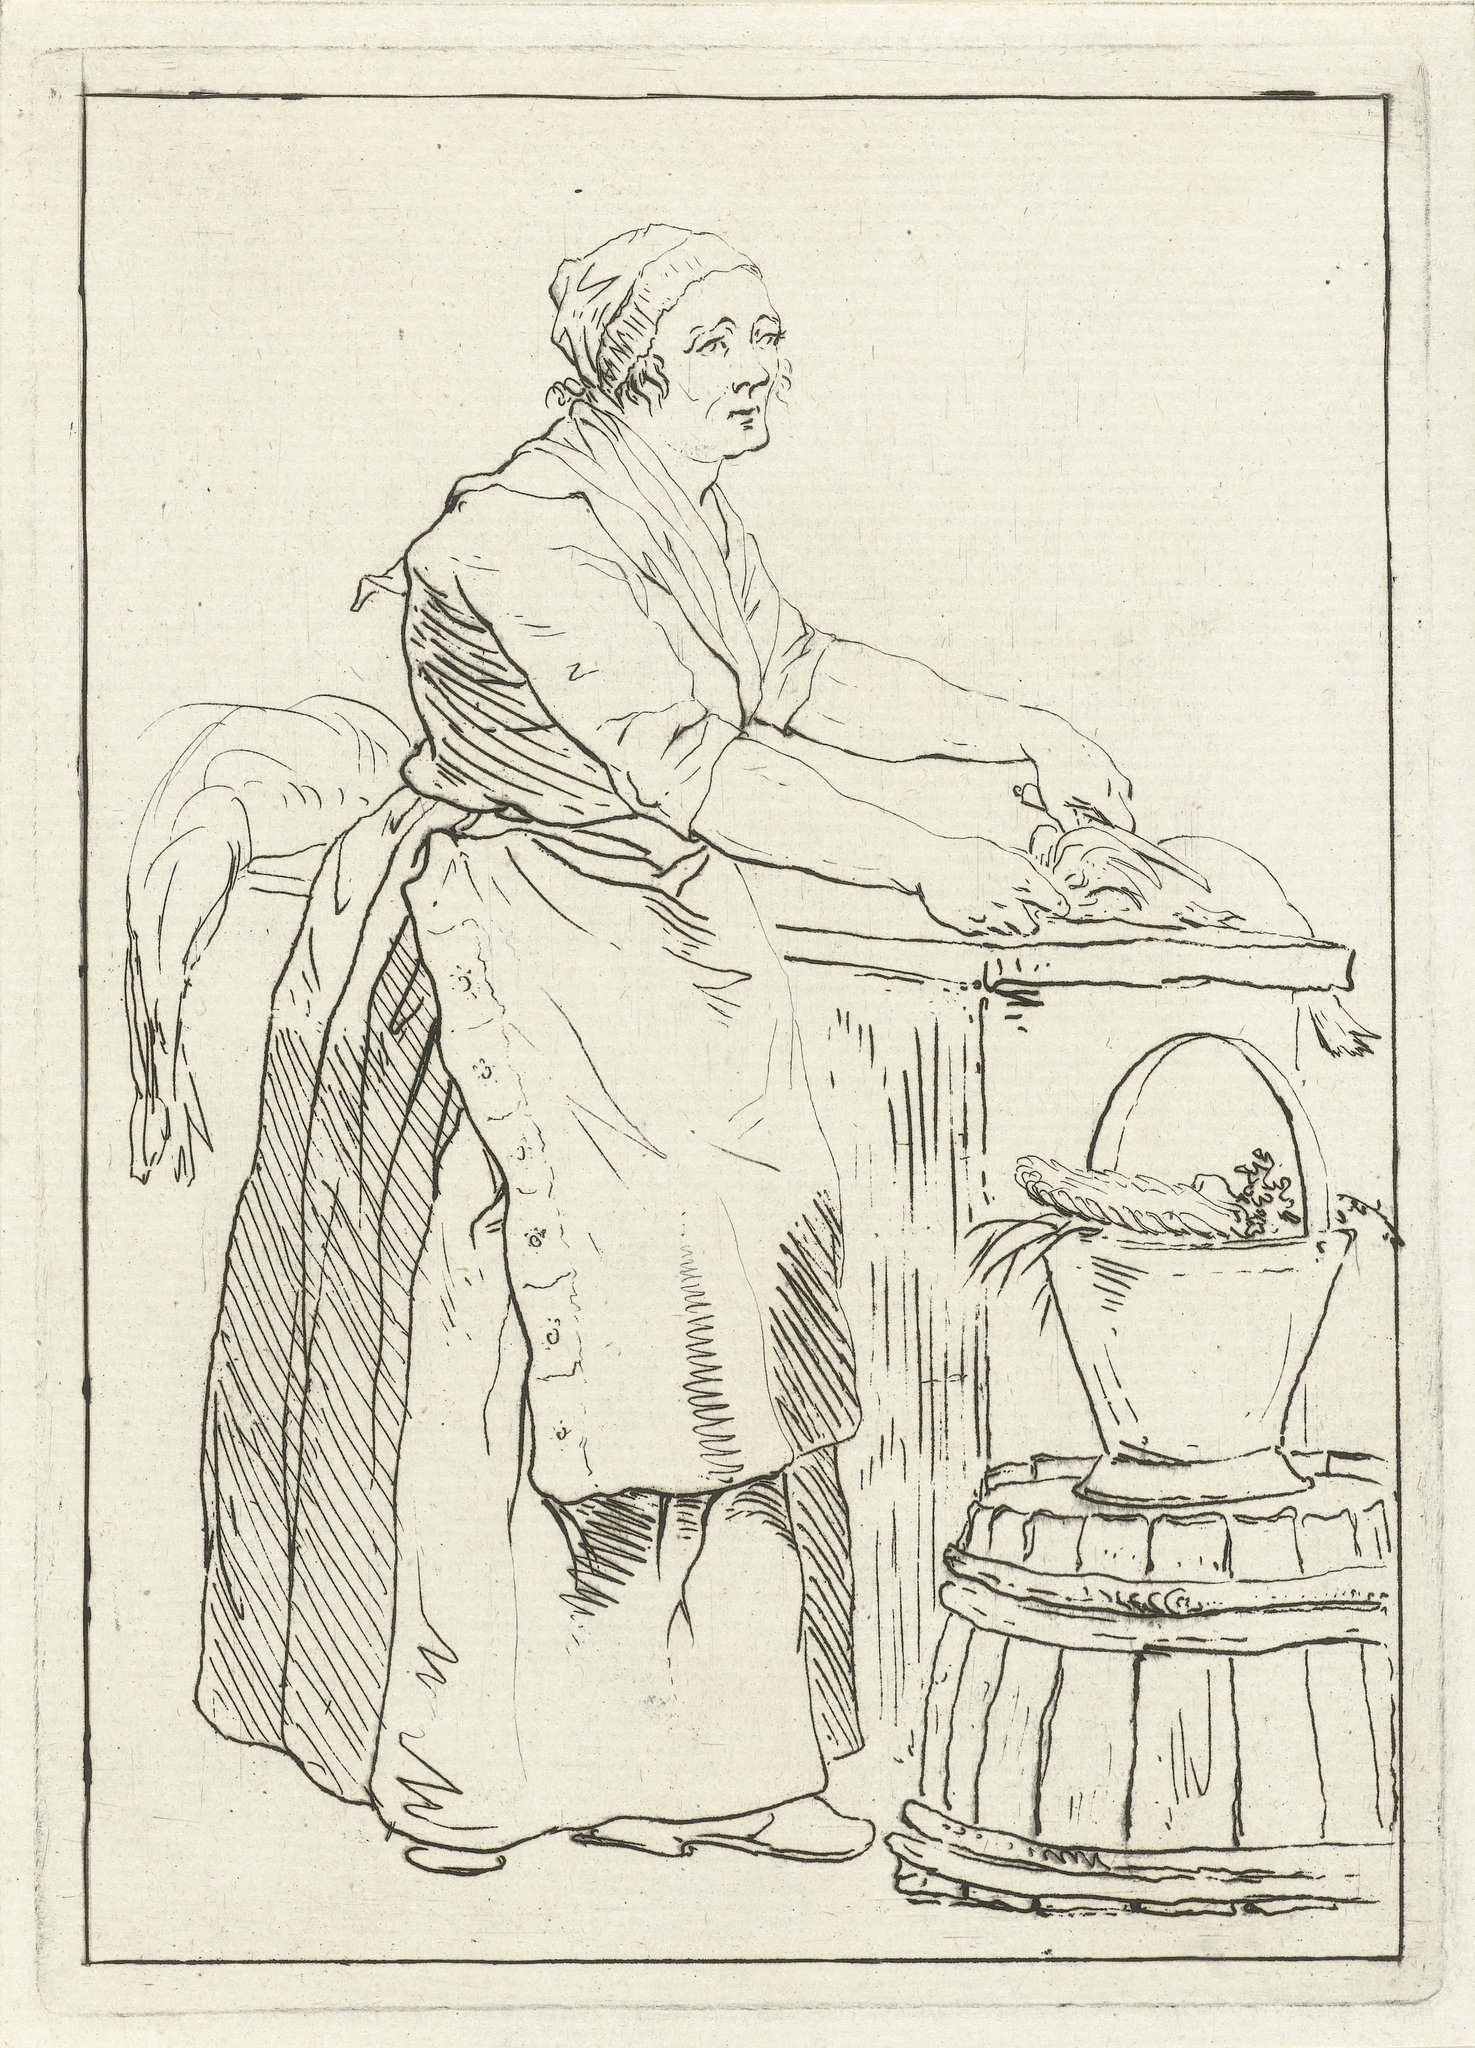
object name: print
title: Vis schoonmakende vrouw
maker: hermanus fock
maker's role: conservator, draughtsman, painter, print maker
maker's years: 1766-1822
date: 1781-1822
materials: paper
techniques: etching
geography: amsterdam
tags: commercial fishery (+ preparing for use or consumption ~ crafts, industries, agriculture)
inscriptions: collector's mark: Lugt 2228